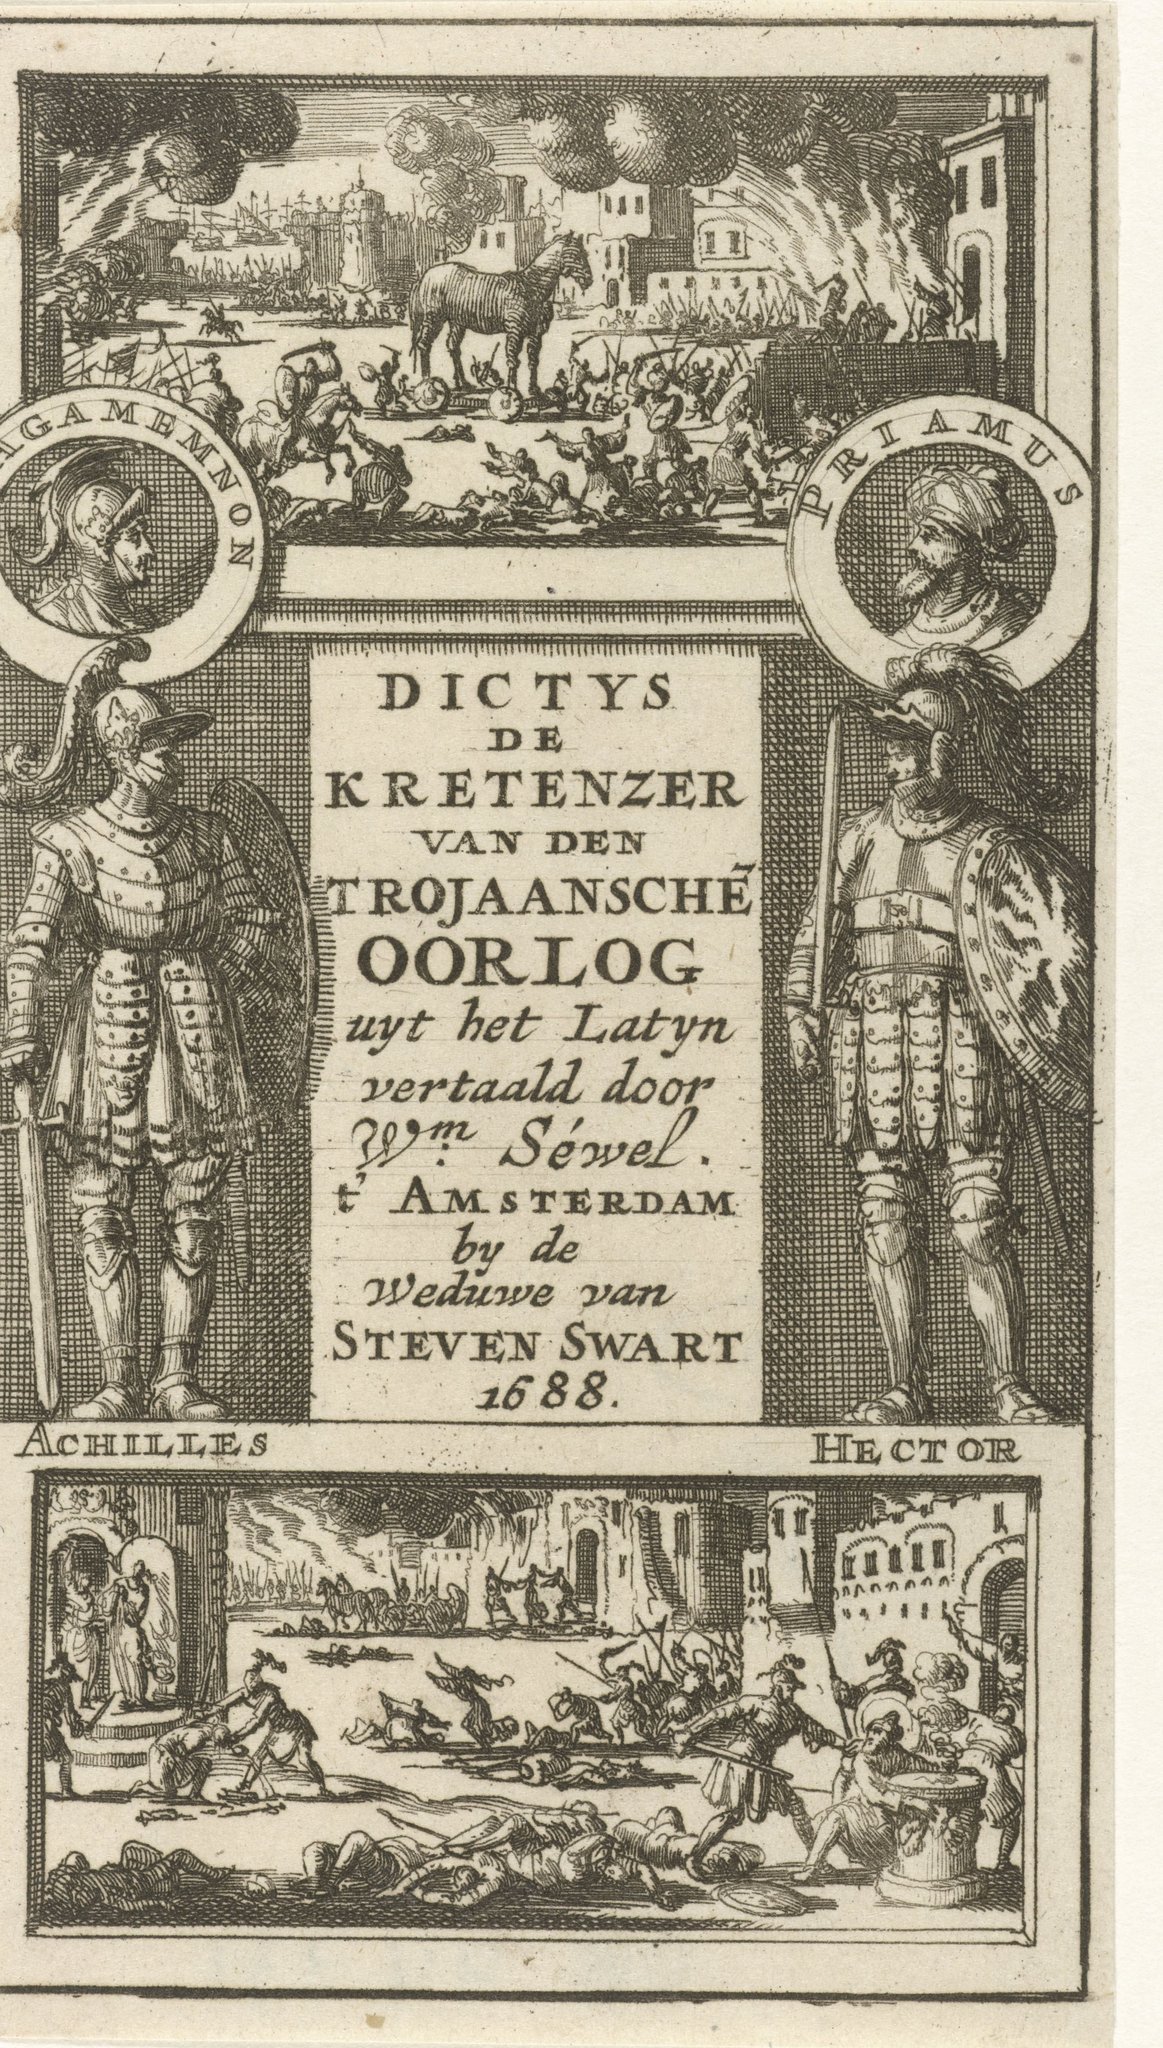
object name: print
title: Titelpagina voor: Dictys Cretensis, Van den Trojaanschen oorlog, 1688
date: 1688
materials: paper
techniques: etching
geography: amsterdam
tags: (story of) priam, agamemnon, hector, (story of) achilles, the fall of troy; troy burning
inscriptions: collector's mark: Lugt 2228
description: Voetstuk met opschrift, geflankeerd door Achilles en Hector. Hierboven een weergave van de verwoesting van Troje met portretmedaillons van Agamemnon en Priamus. Onder een vergelijkbare voorstelling van de verwoesting van Troje met de dood van Priamus.